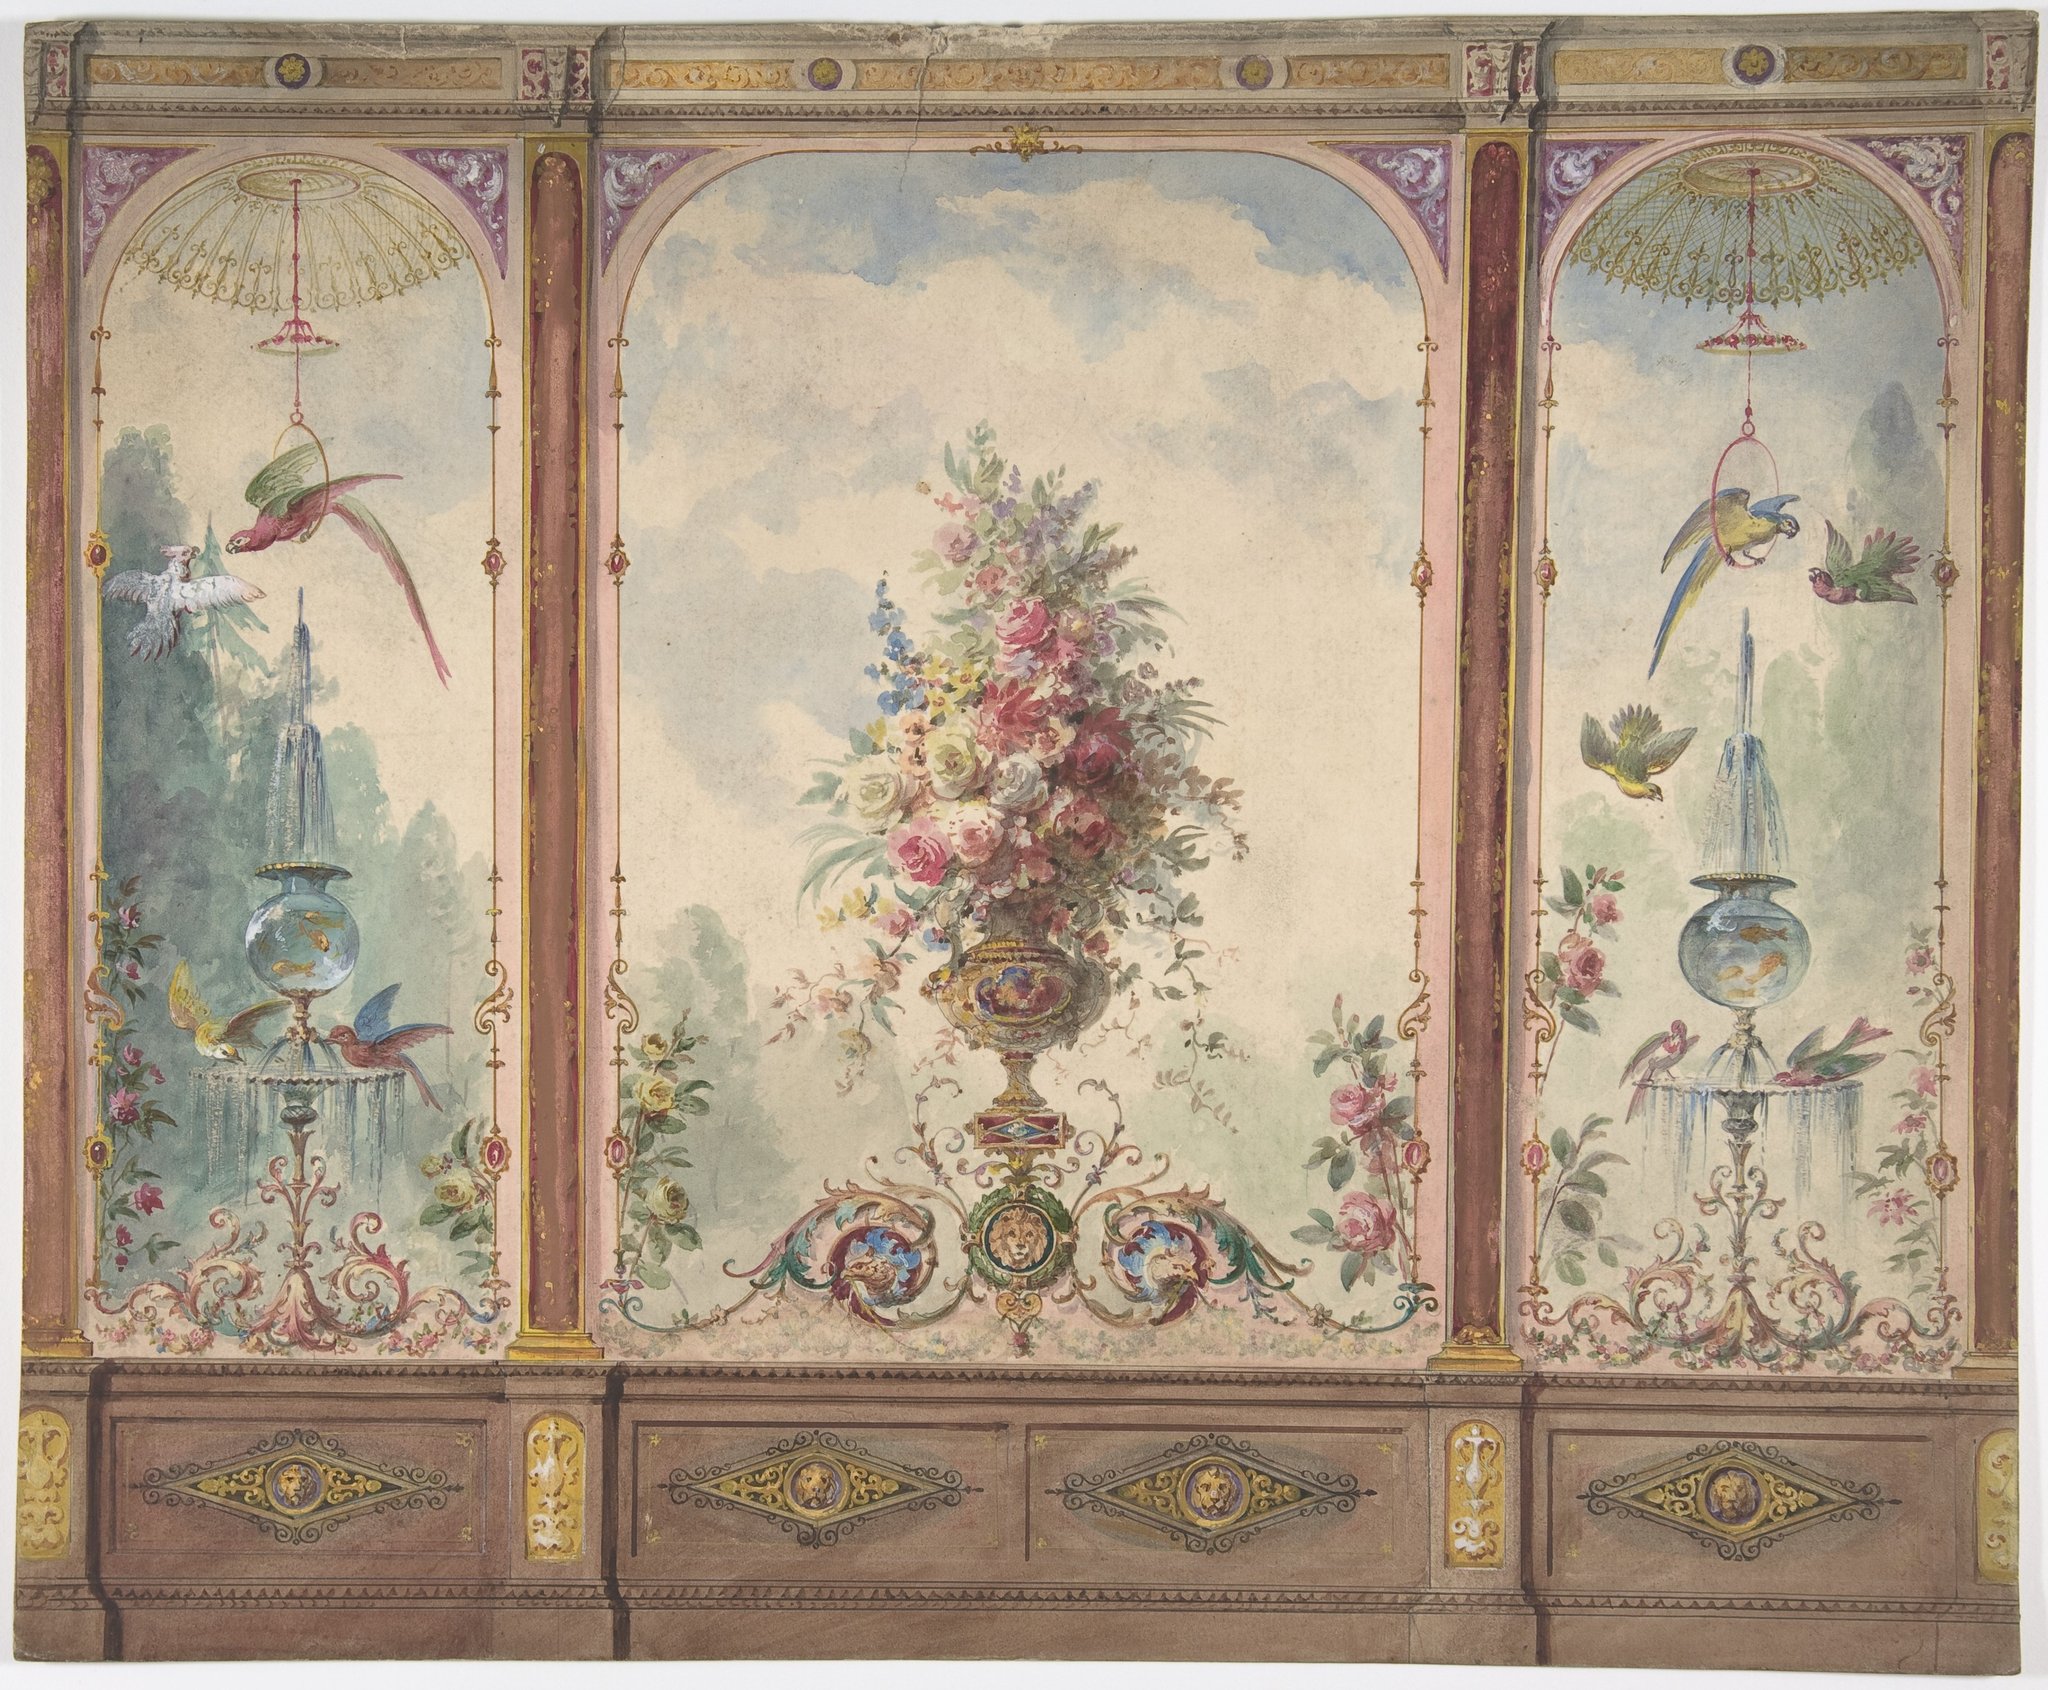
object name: drawing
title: Design for a Wall with a Flower Vase, Birds, Two Gold Fish and Globe Fountains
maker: anonymous, british, 19th century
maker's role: artist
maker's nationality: british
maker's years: 1800-1900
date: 1801-1900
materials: ink, watercolor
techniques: pen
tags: birds,fountains,roses,vases